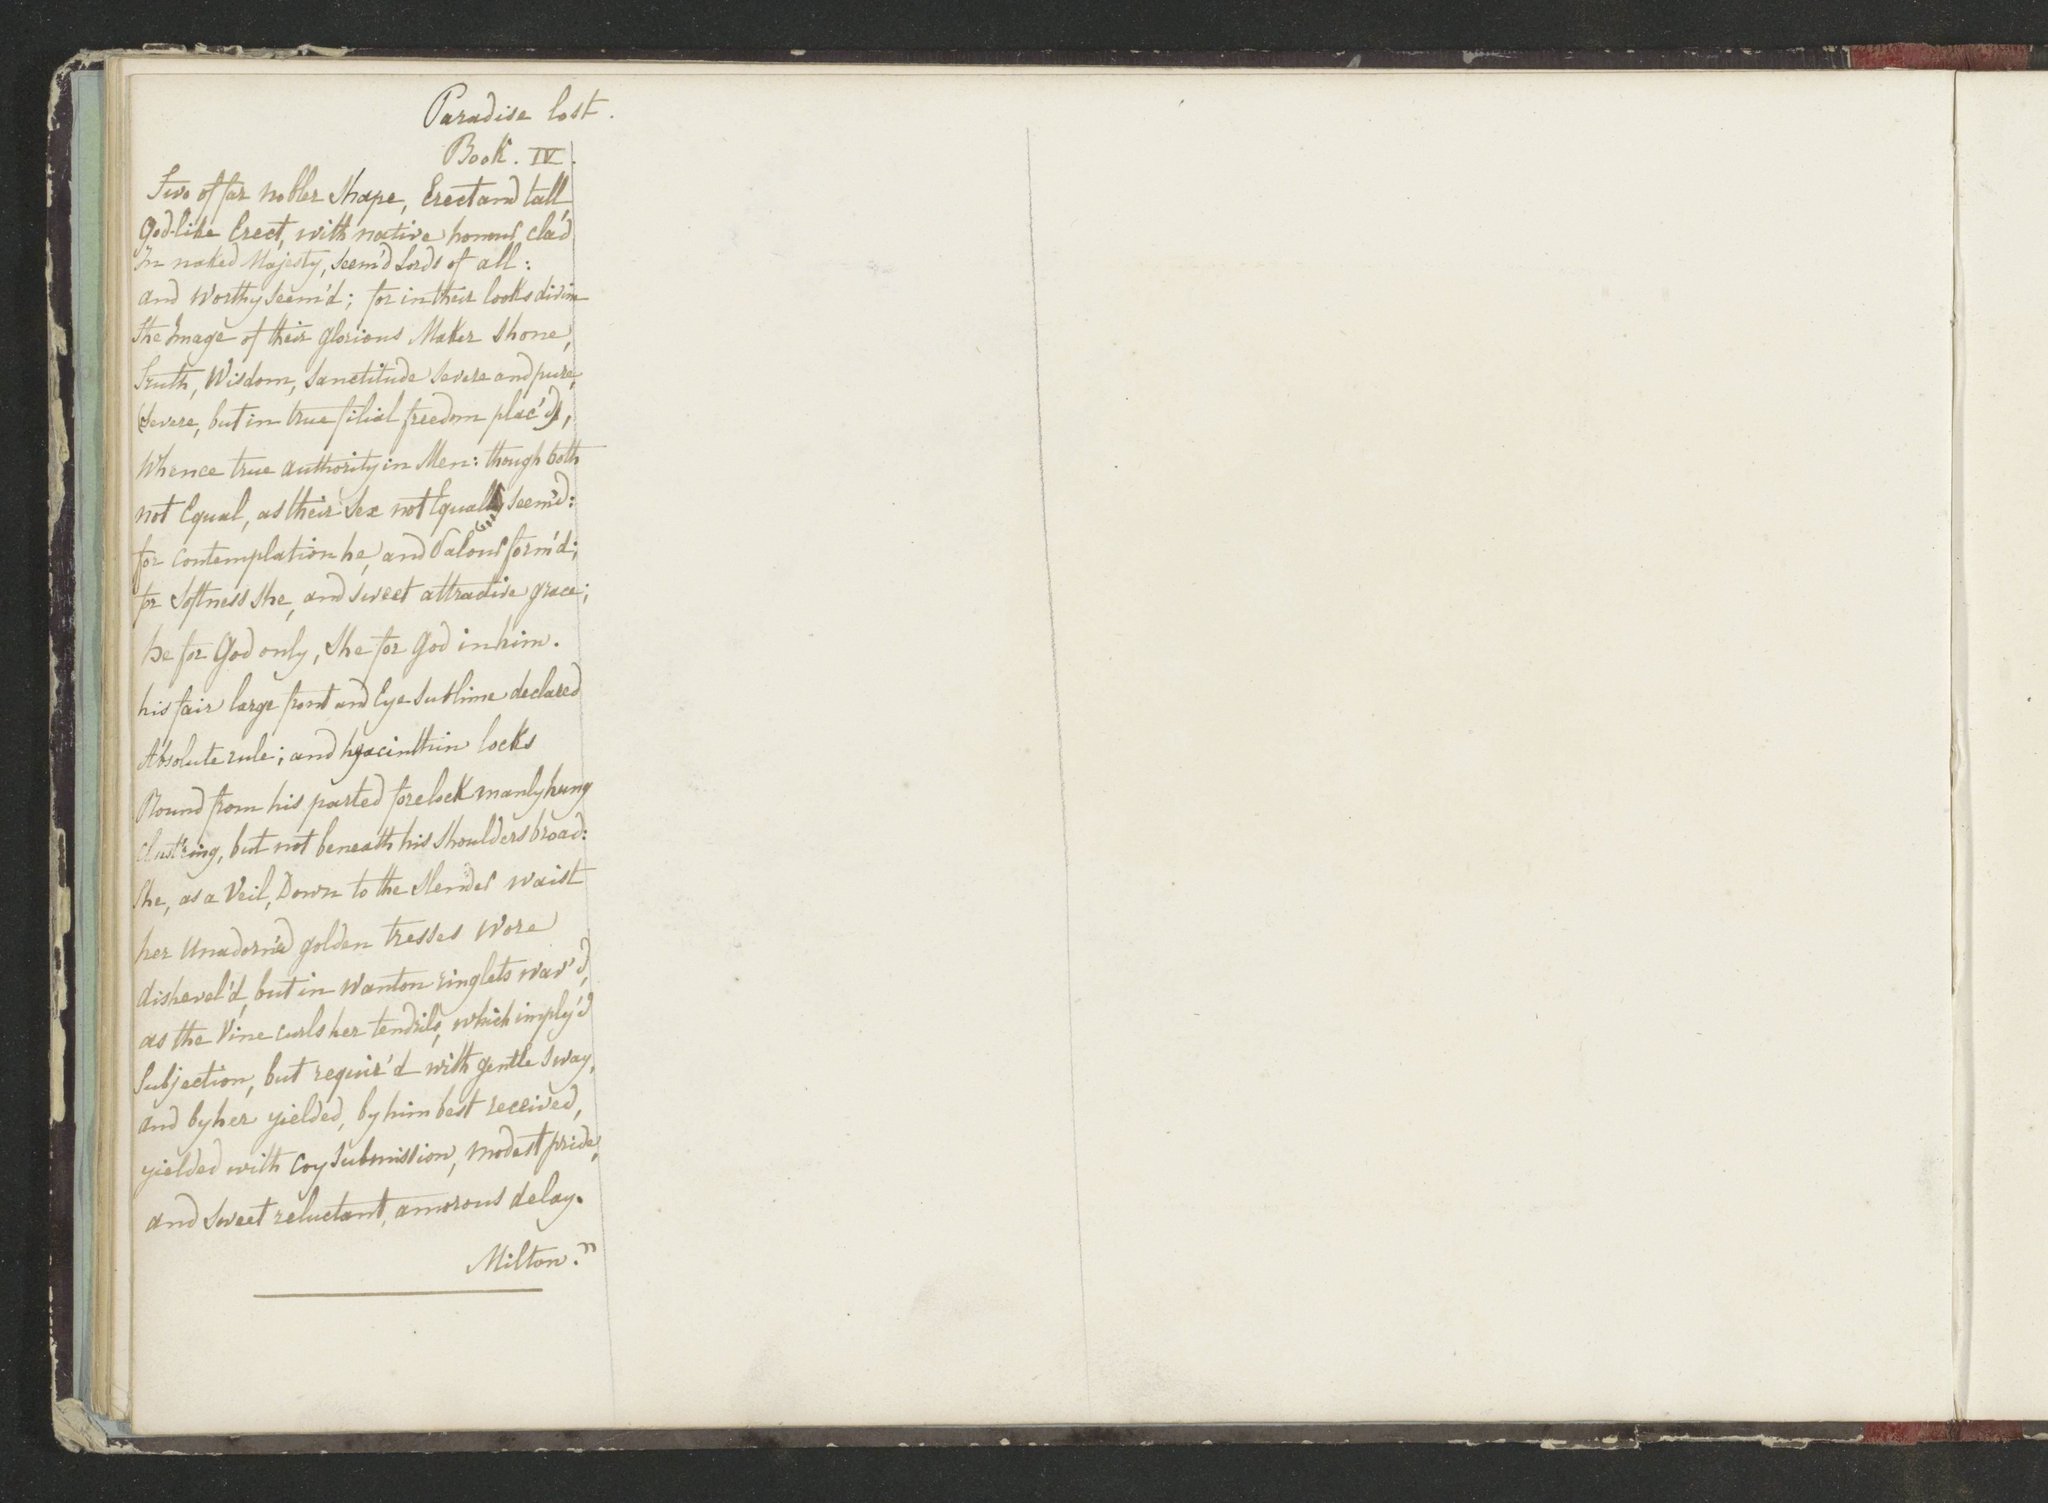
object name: sketchbook leaf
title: Fragment uit boek IV van Miltons 'Paradise Lost'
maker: Anonymous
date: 1819-1870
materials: ink, paper, pencil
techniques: pen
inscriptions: annotation: ‘Paradise lost./ Book IV ... reluctant, amorous delay./ Milton."’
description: Blad 10 verso uit een schetsboek met 39 bladen.